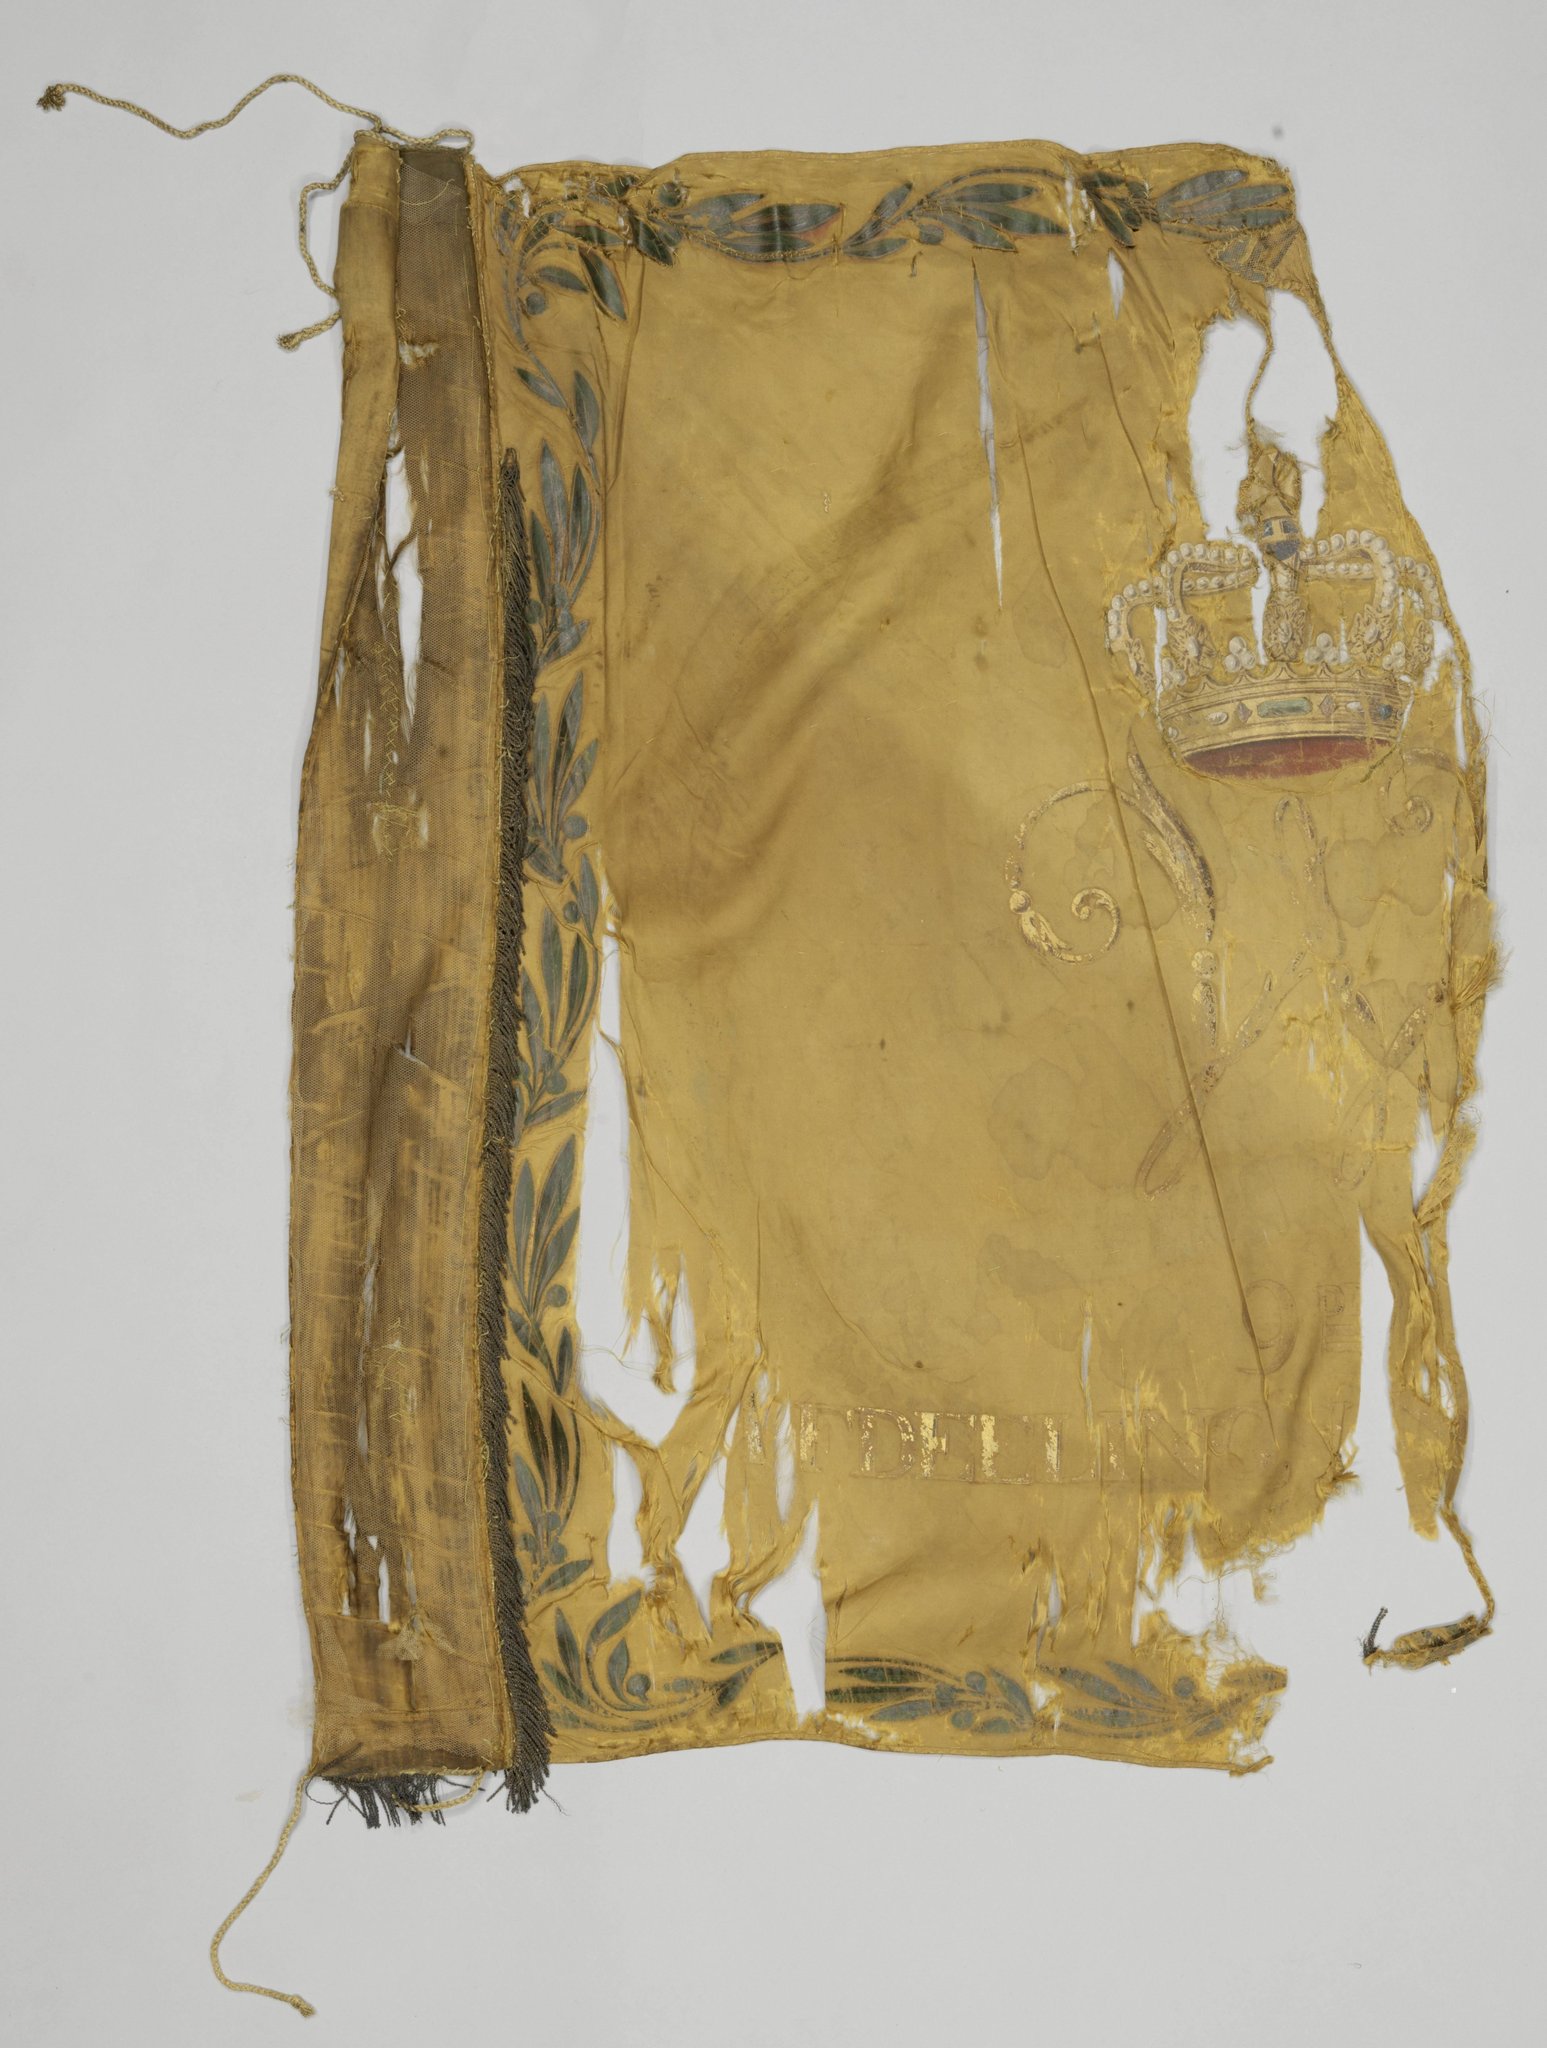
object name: banner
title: Fragment van vaandel van de negende afdeling infanterie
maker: jan willem pieneman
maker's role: draughtsman, painter, print maker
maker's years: 1779-1853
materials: bronze, silk, wood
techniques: painted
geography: netherlands